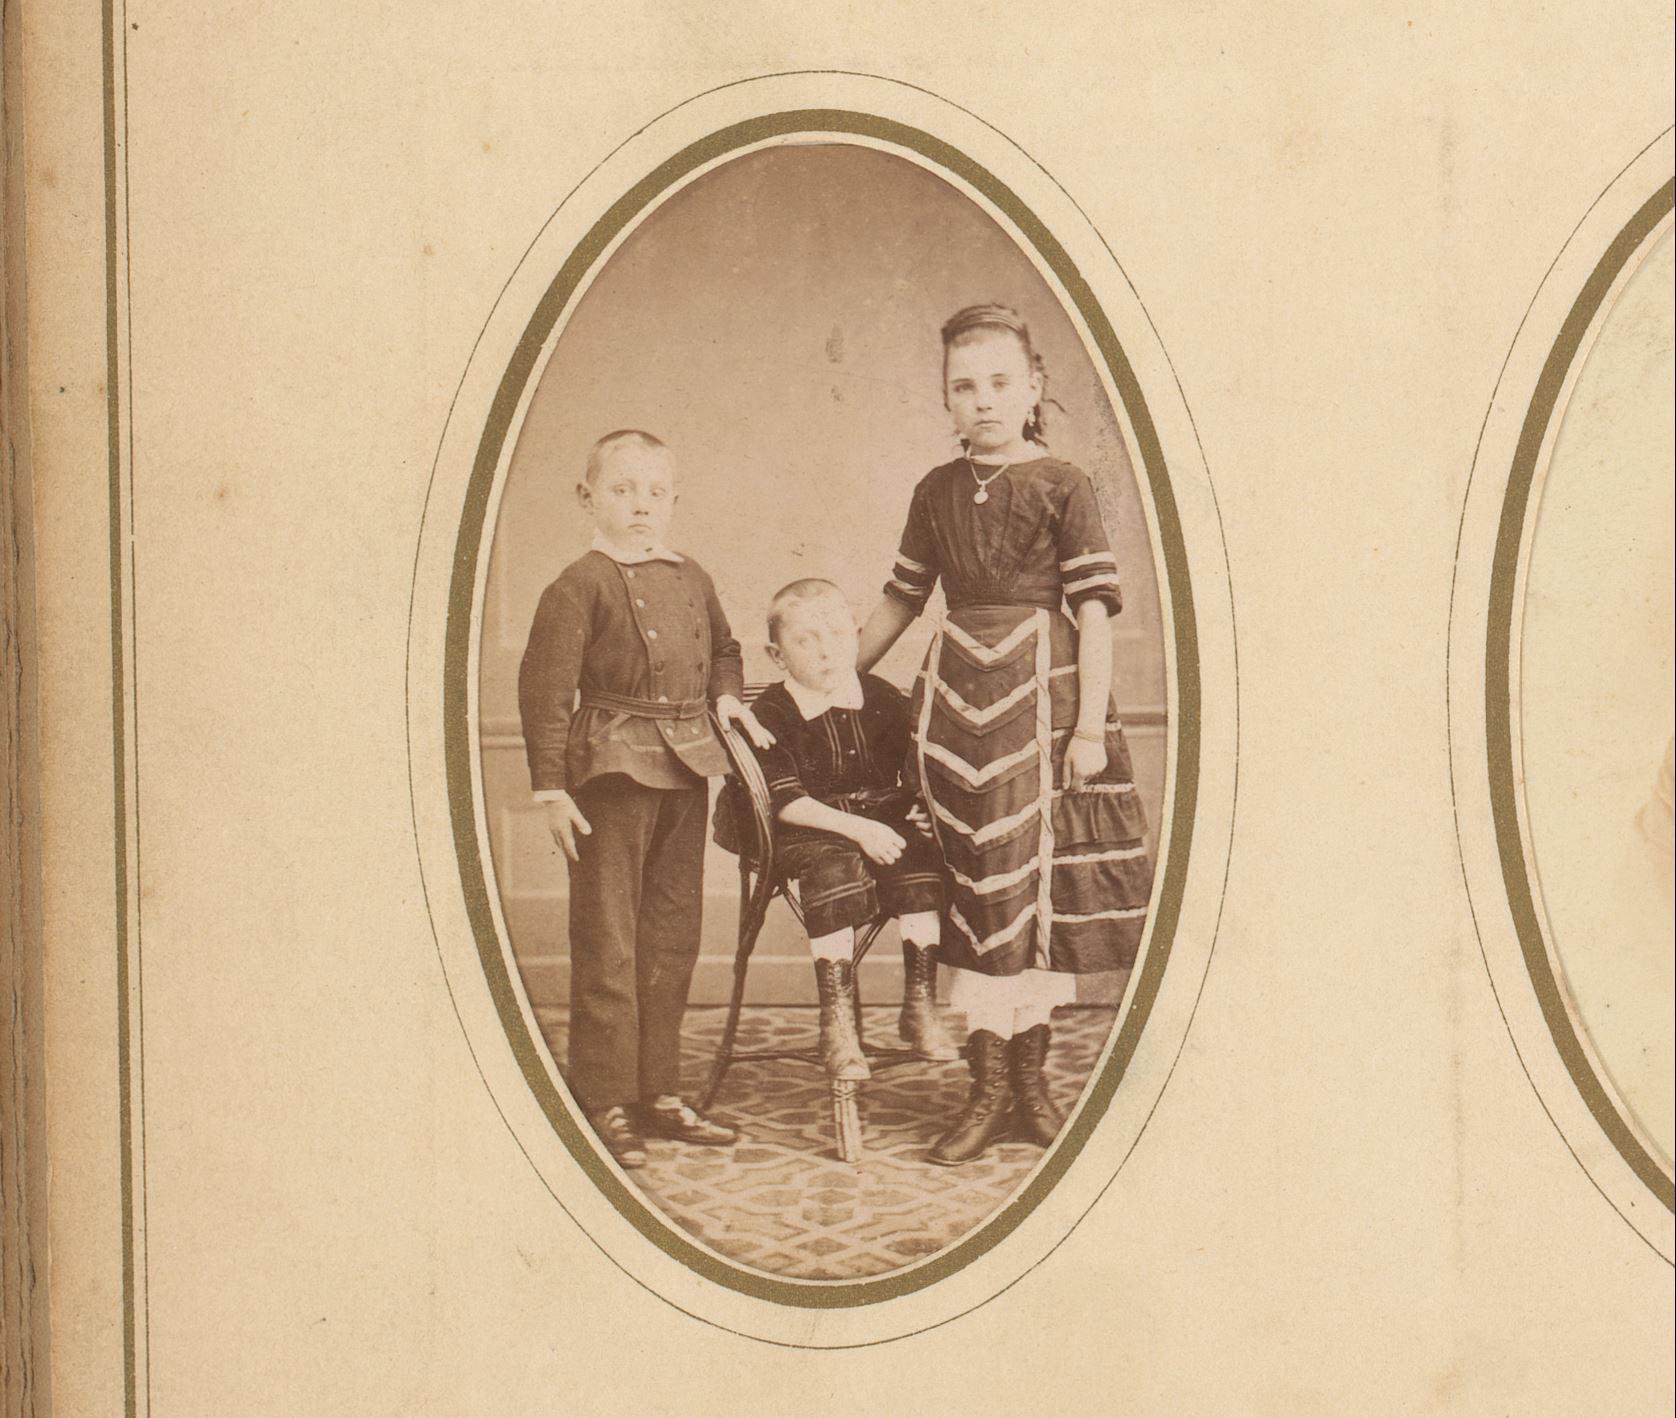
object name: photograph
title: Portret van drie kinderen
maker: hermanus siderius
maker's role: draughtsman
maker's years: 1819-1892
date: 1850-1884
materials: cardboard, photographic support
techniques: albumen print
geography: harlingen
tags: child (+ three persons), anonymous historical persons portrayed in a group, in a group-portrait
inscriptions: inscription: ‘H. SIDERIUS/ HARLINGEN’